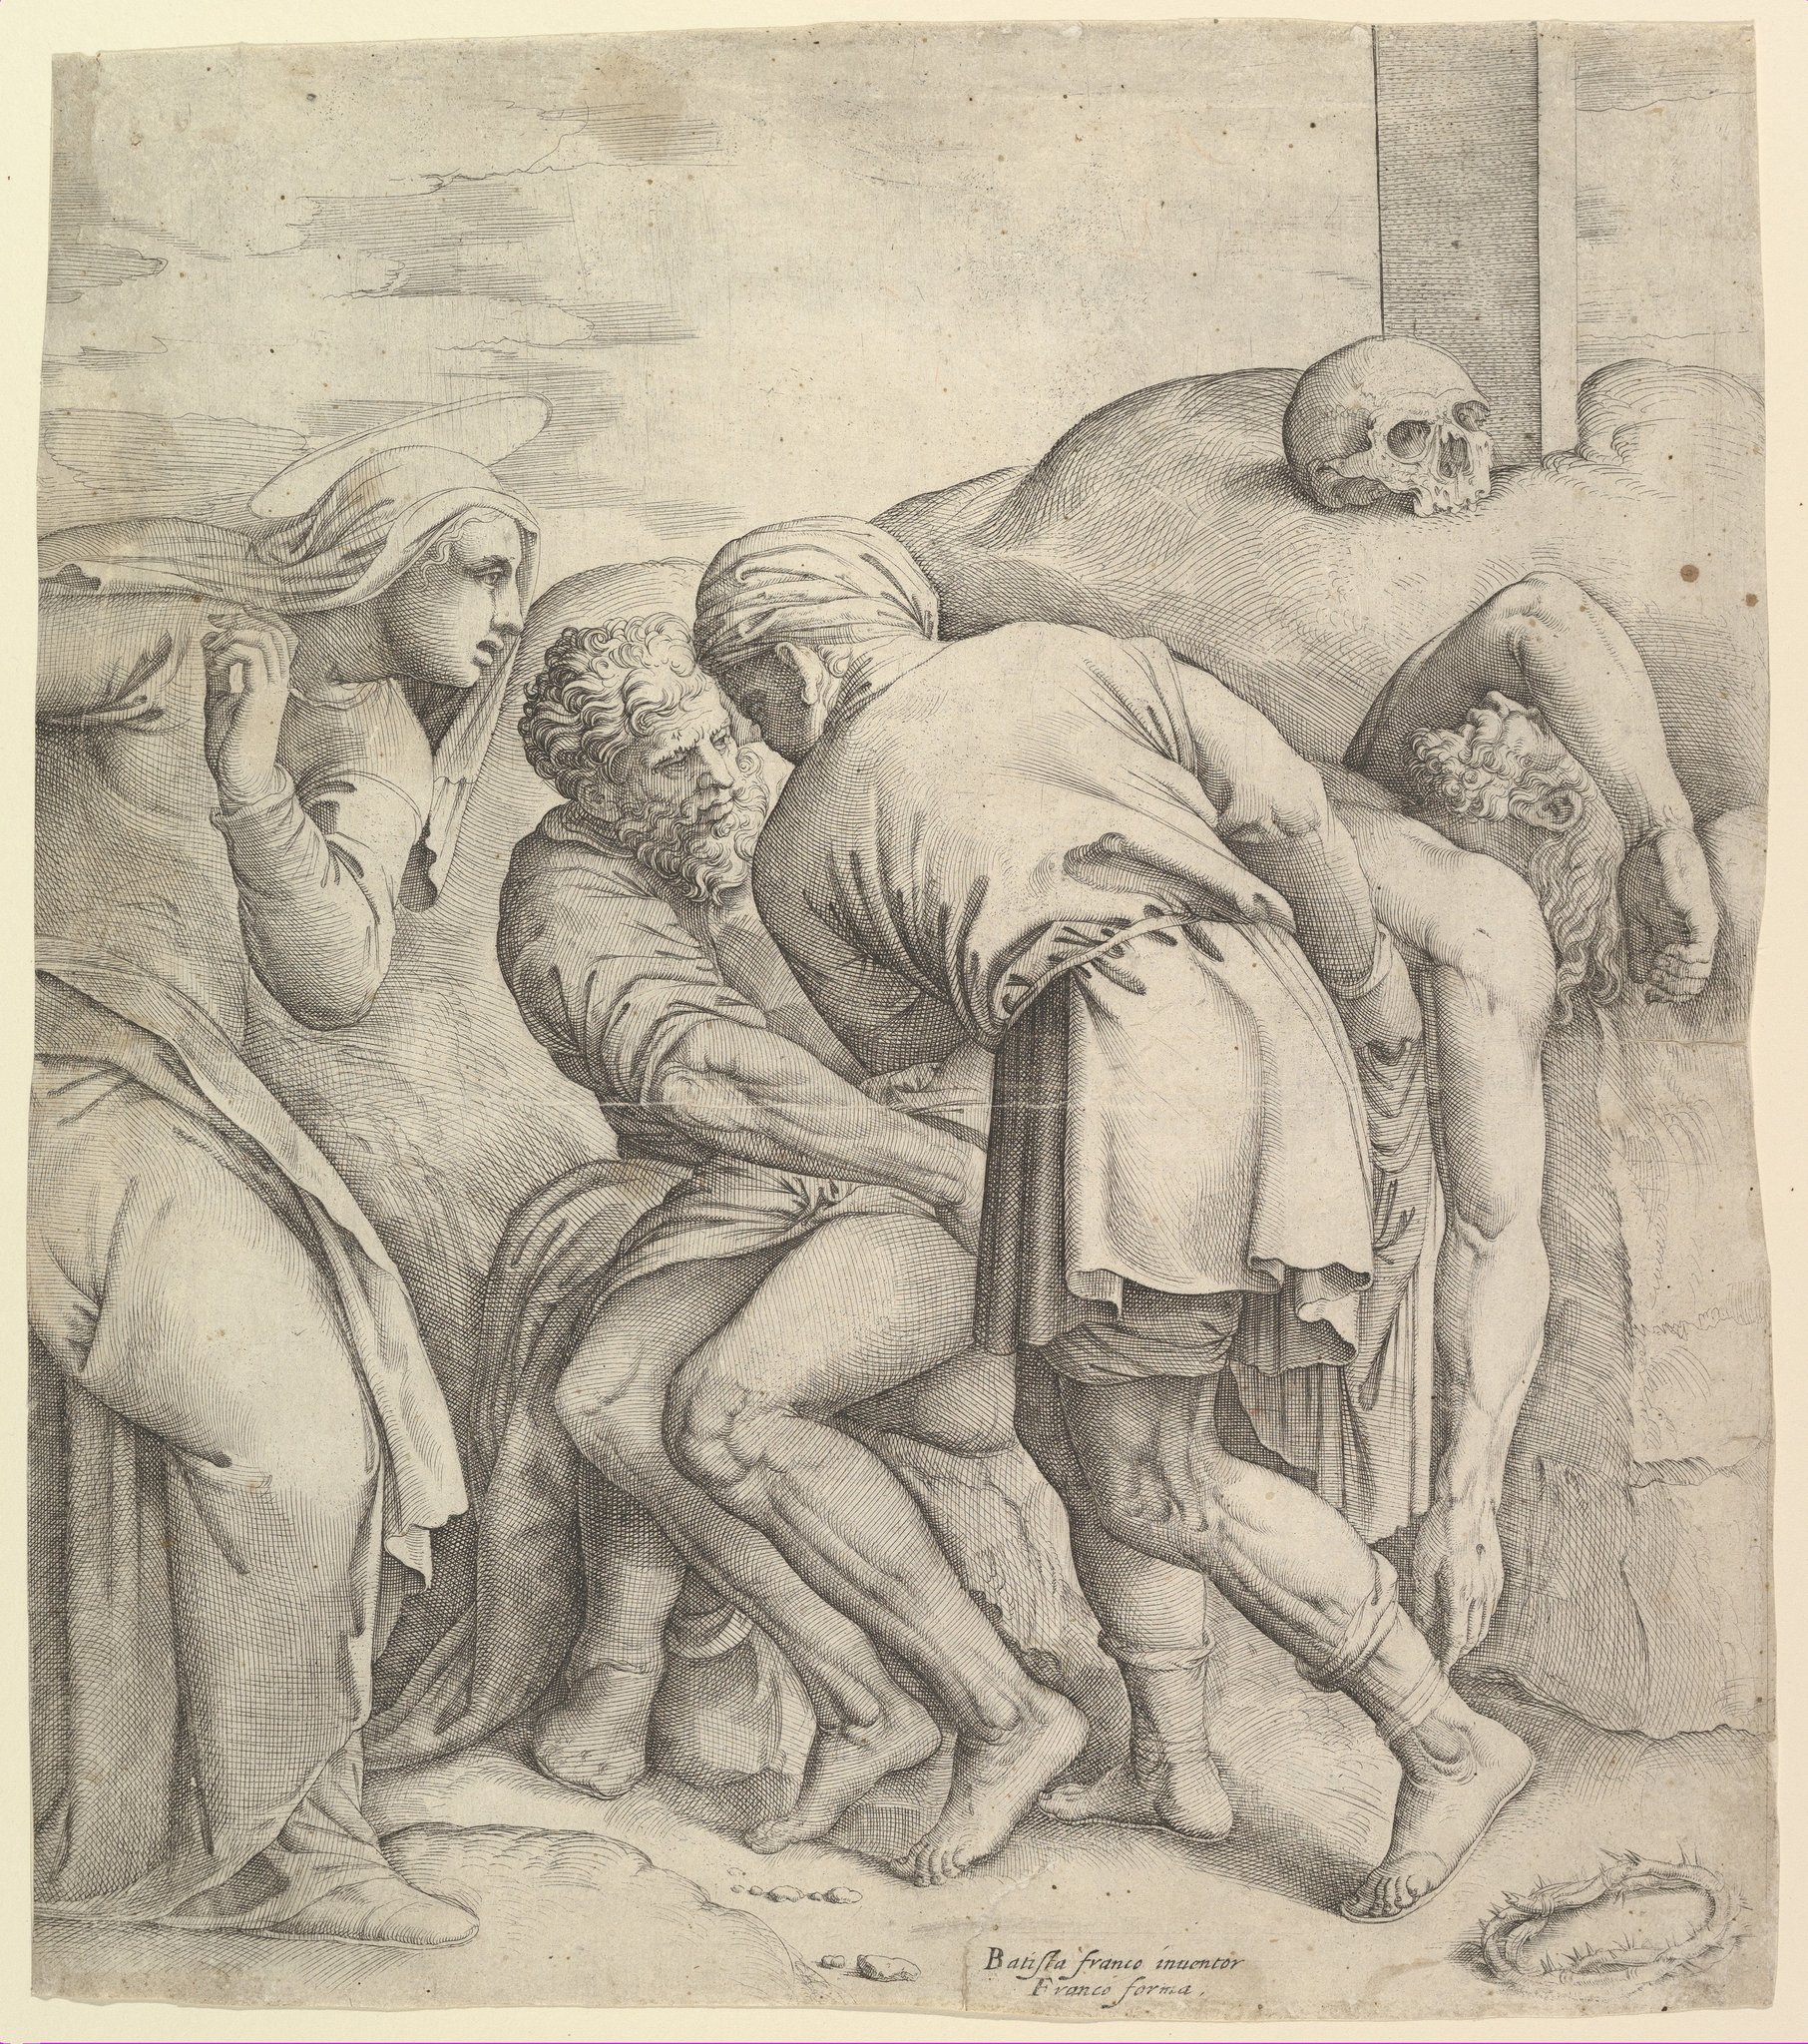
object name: print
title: The Entombment of Christ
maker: battista franco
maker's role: artist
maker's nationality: italian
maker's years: 1510-1561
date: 1530-1561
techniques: engraving, etching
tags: christ,virgin mary,entombment